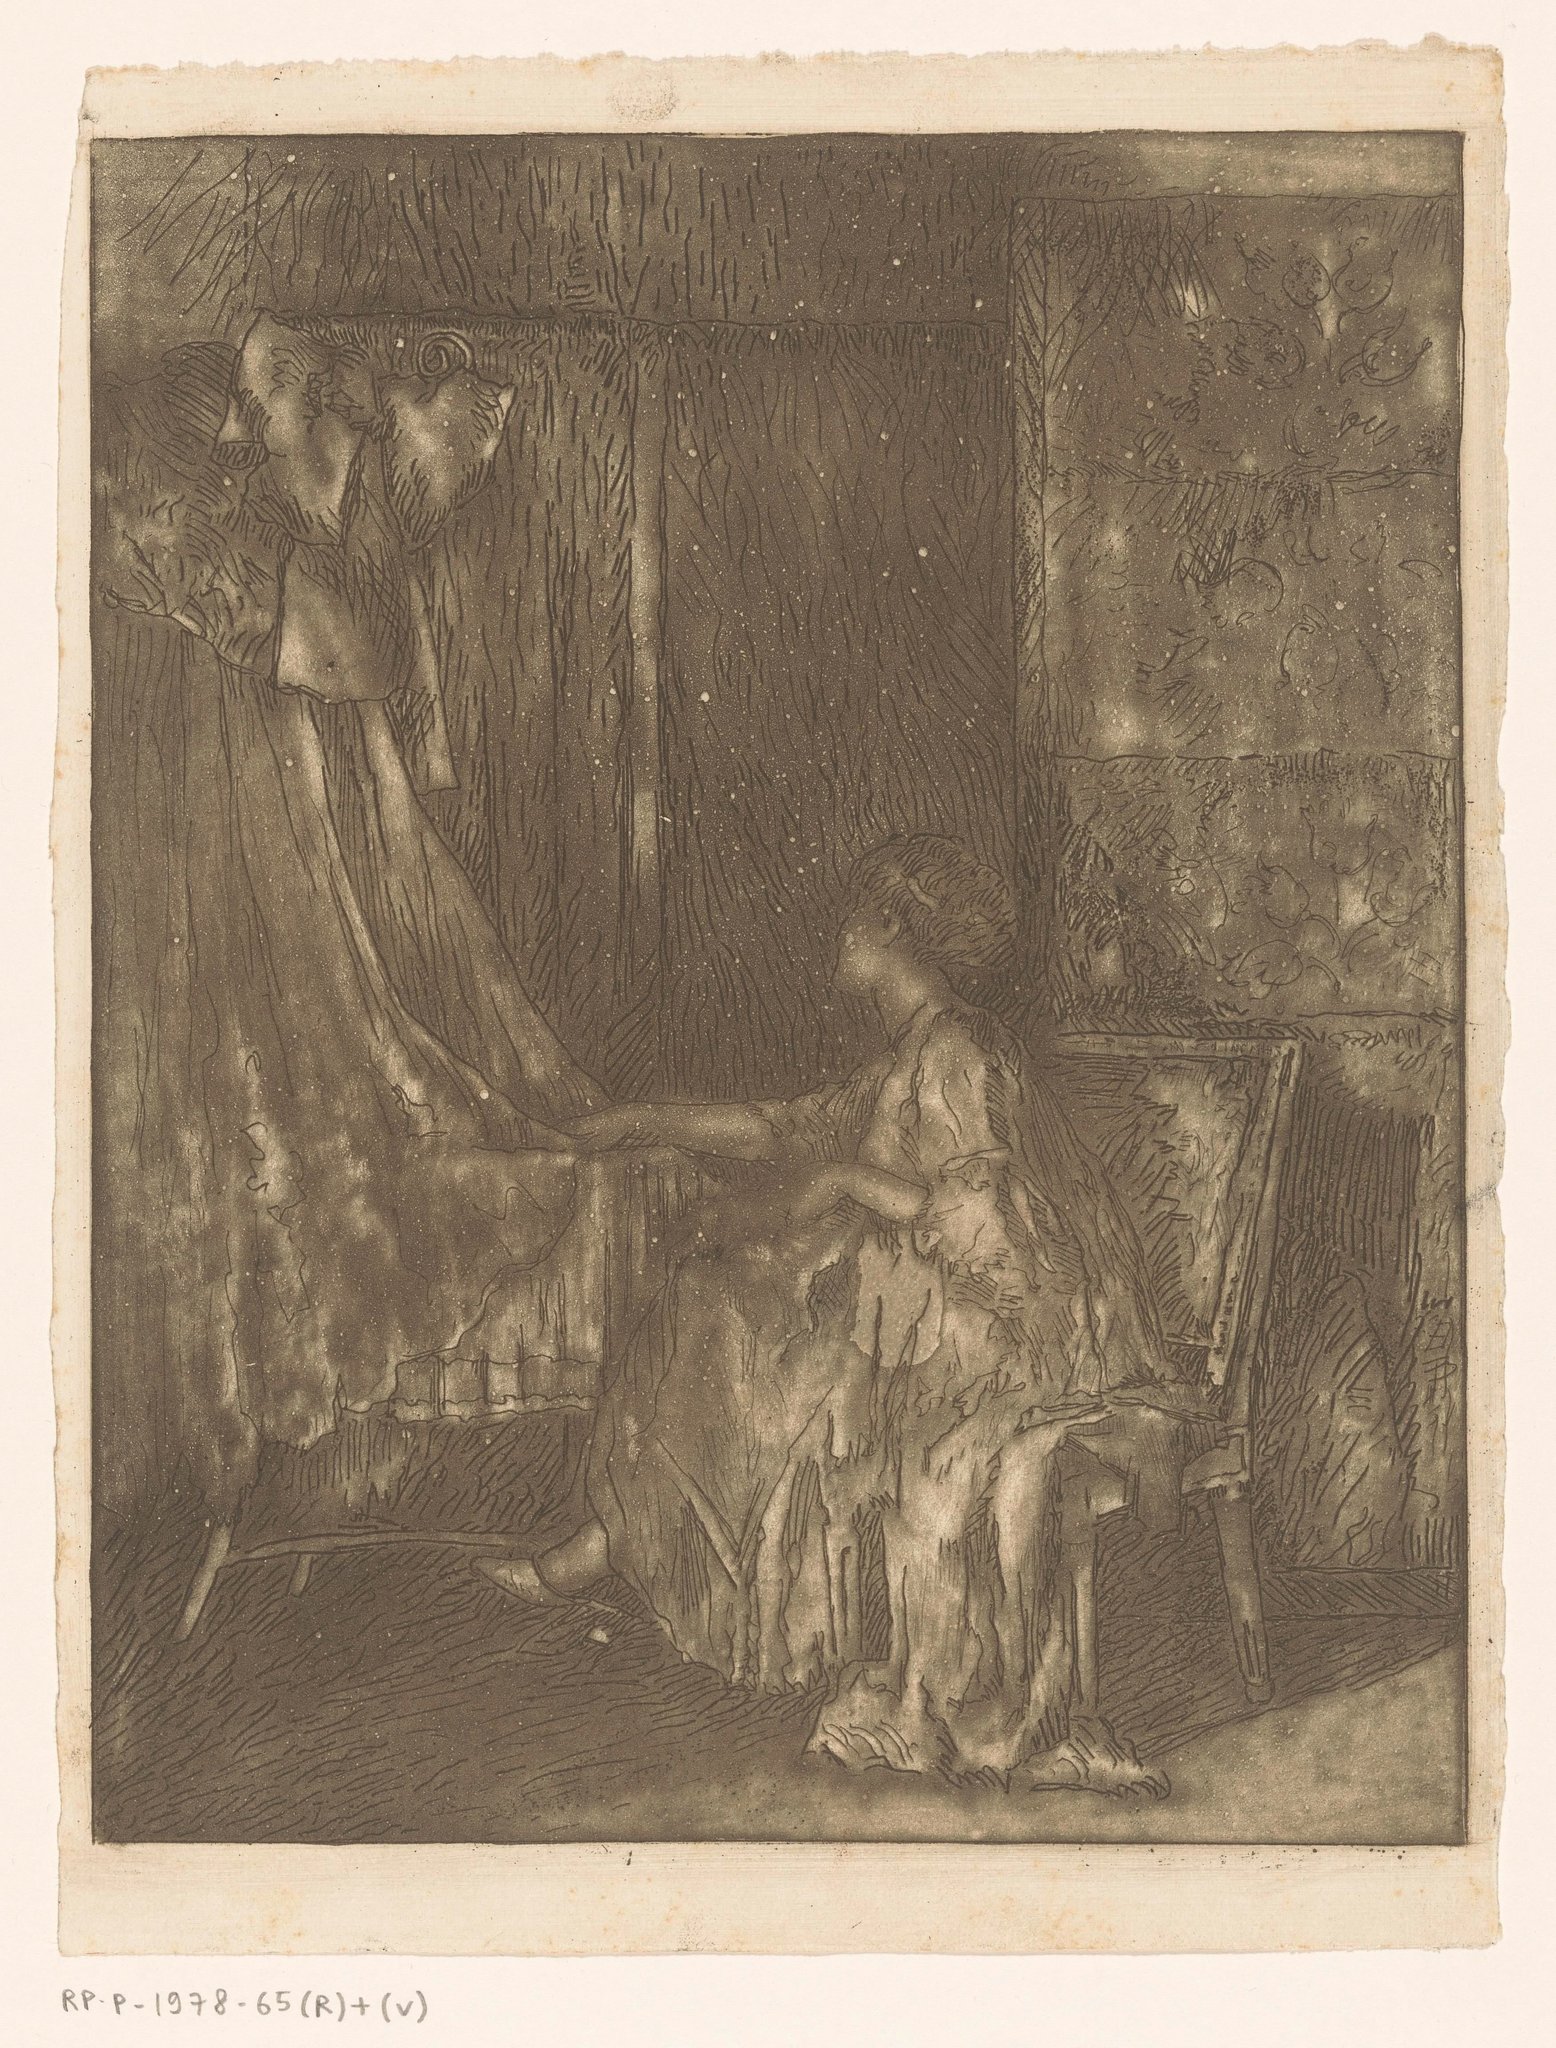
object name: print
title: Vrouw die op een stoel naast een wieg zit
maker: albert roelofs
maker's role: print maker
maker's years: 1877-1920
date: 1887-1920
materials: paper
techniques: aquatint, etching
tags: cradle, crib, mother and child(ren), woman and child(ren) (family group)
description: De vrouw leunt met haar arm op de rand van de wieg.